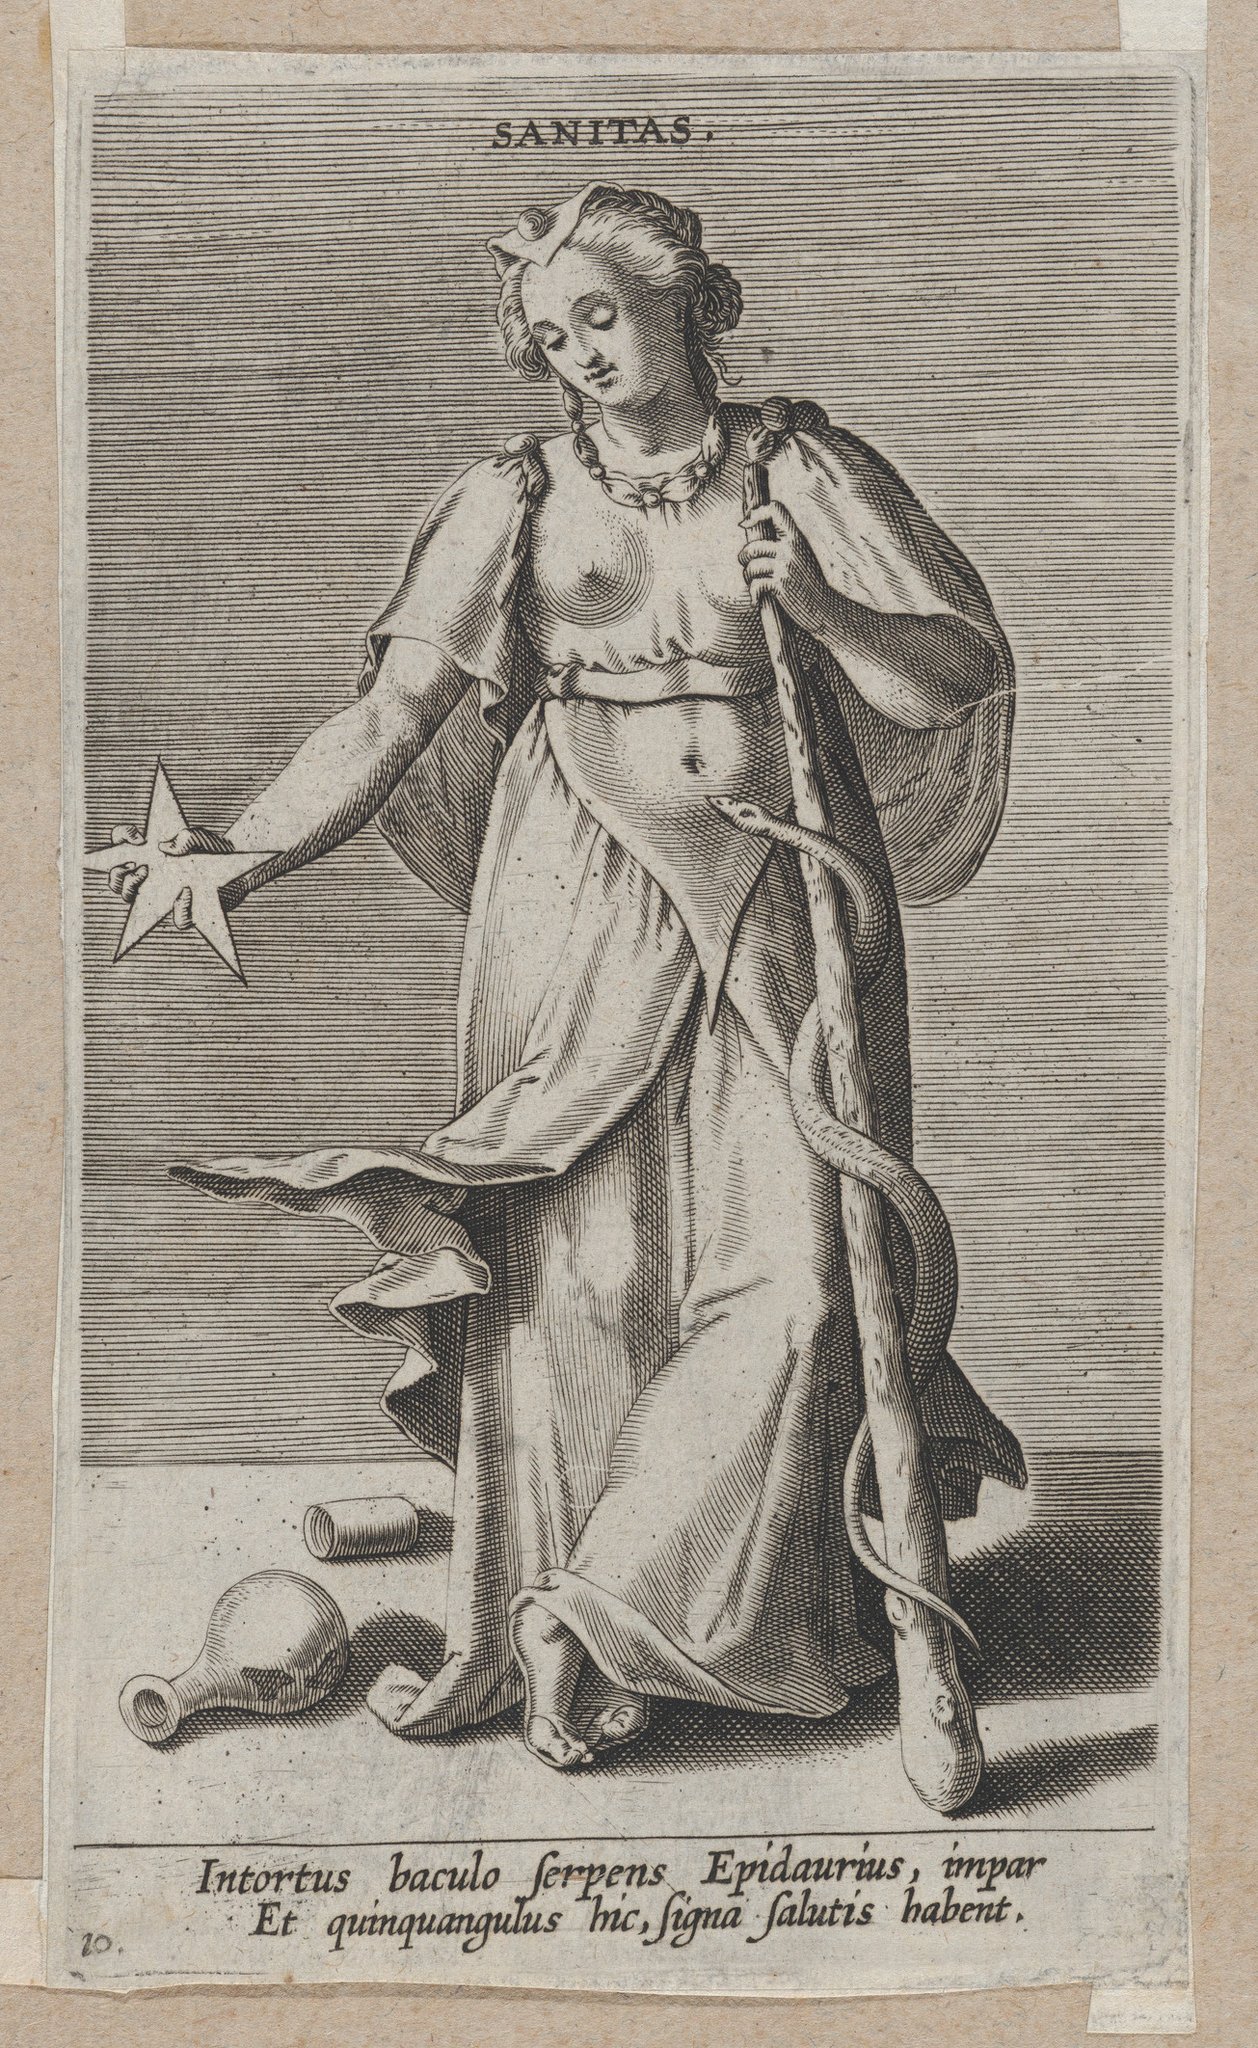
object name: print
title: Sanitas, from "Proposopographia"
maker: philips galle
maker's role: artist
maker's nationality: netherlandish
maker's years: 1537-1612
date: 1585-1590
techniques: engraving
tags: women